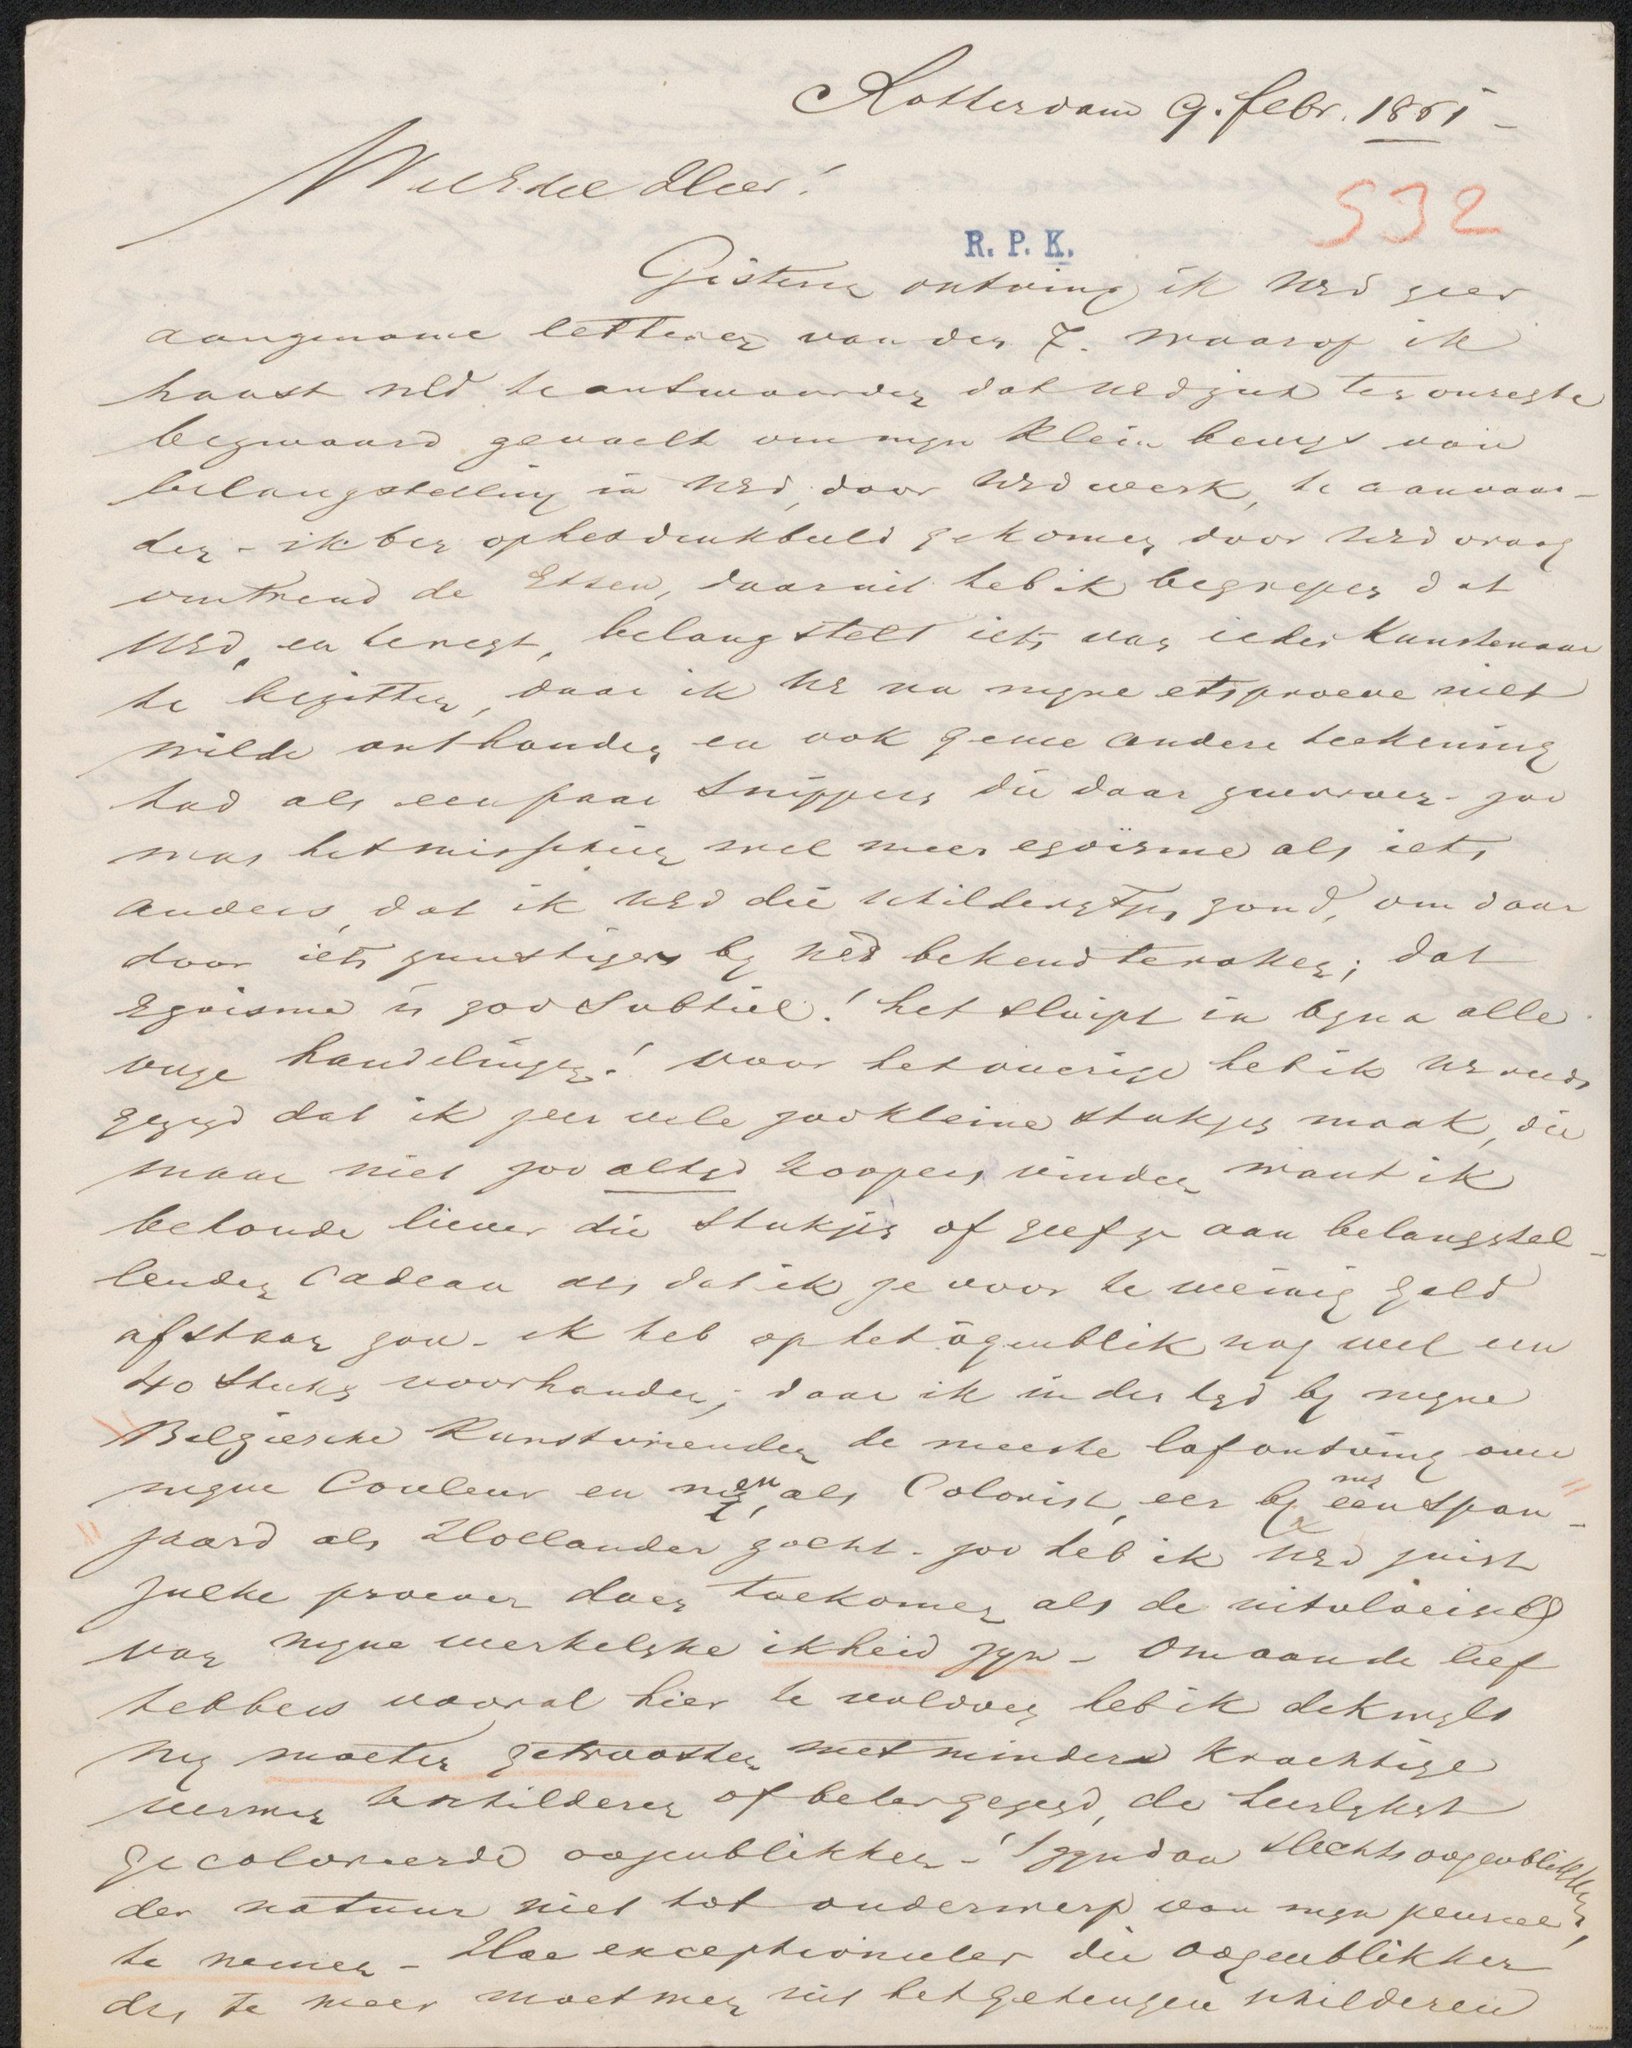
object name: letter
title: Brief aan Christiaan Kramm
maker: johannes tavenraat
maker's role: draughtsman, painter, print maker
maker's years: 1809-1881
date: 1861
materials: ink, paper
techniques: pen, writing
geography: rotterdam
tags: hendrik tollens, edouard hamman, utrecht, print maker, draughtsman, christiaan kramm, literature ~ arts, the graphic arts, painting (including book-illumination, miniature-painting), art collecting, paris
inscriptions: collector's mark: Lugt 2233, seal